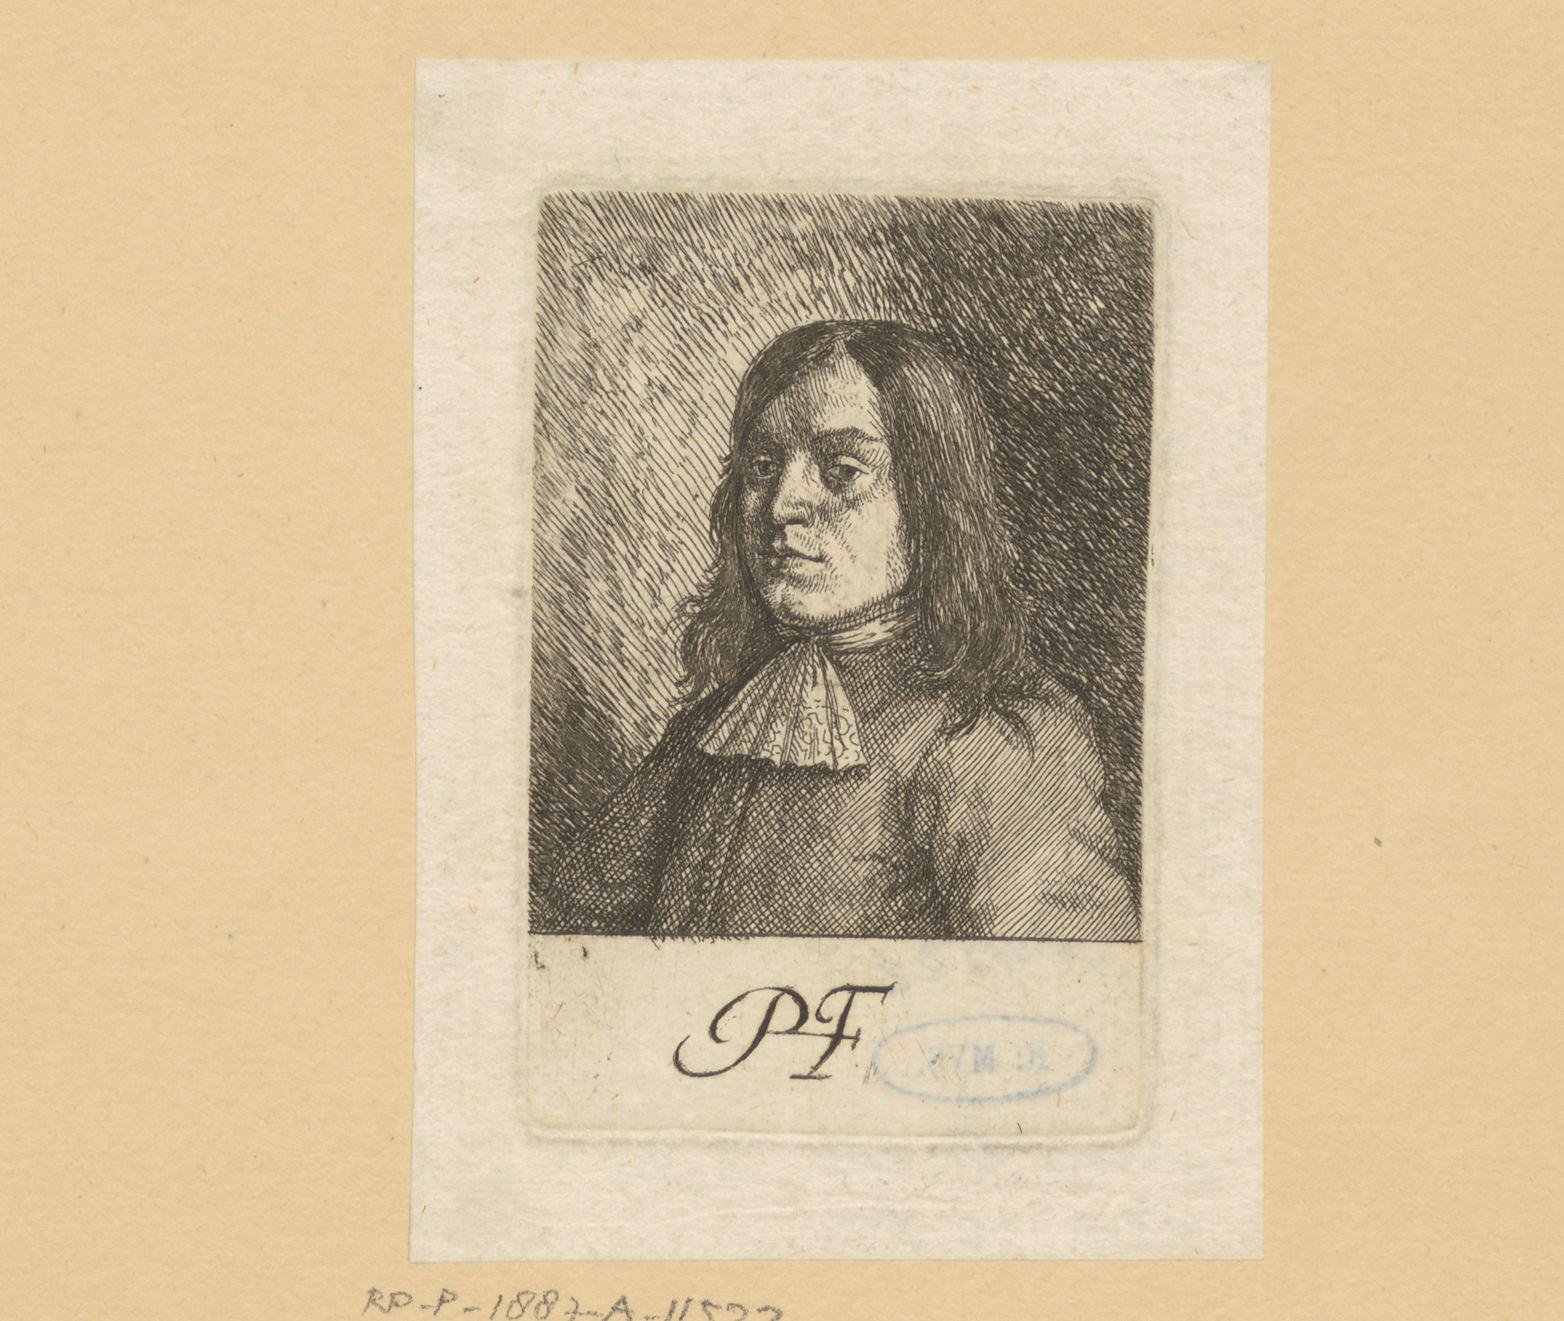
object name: print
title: Portret van Peter Hieronymus Frisch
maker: stephan strauch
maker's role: painter, print maker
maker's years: 1645-1677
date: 1655-1677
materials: paper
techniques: etching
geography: nuremberg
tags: historical persons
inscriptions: collector's mark: Lugt 2228